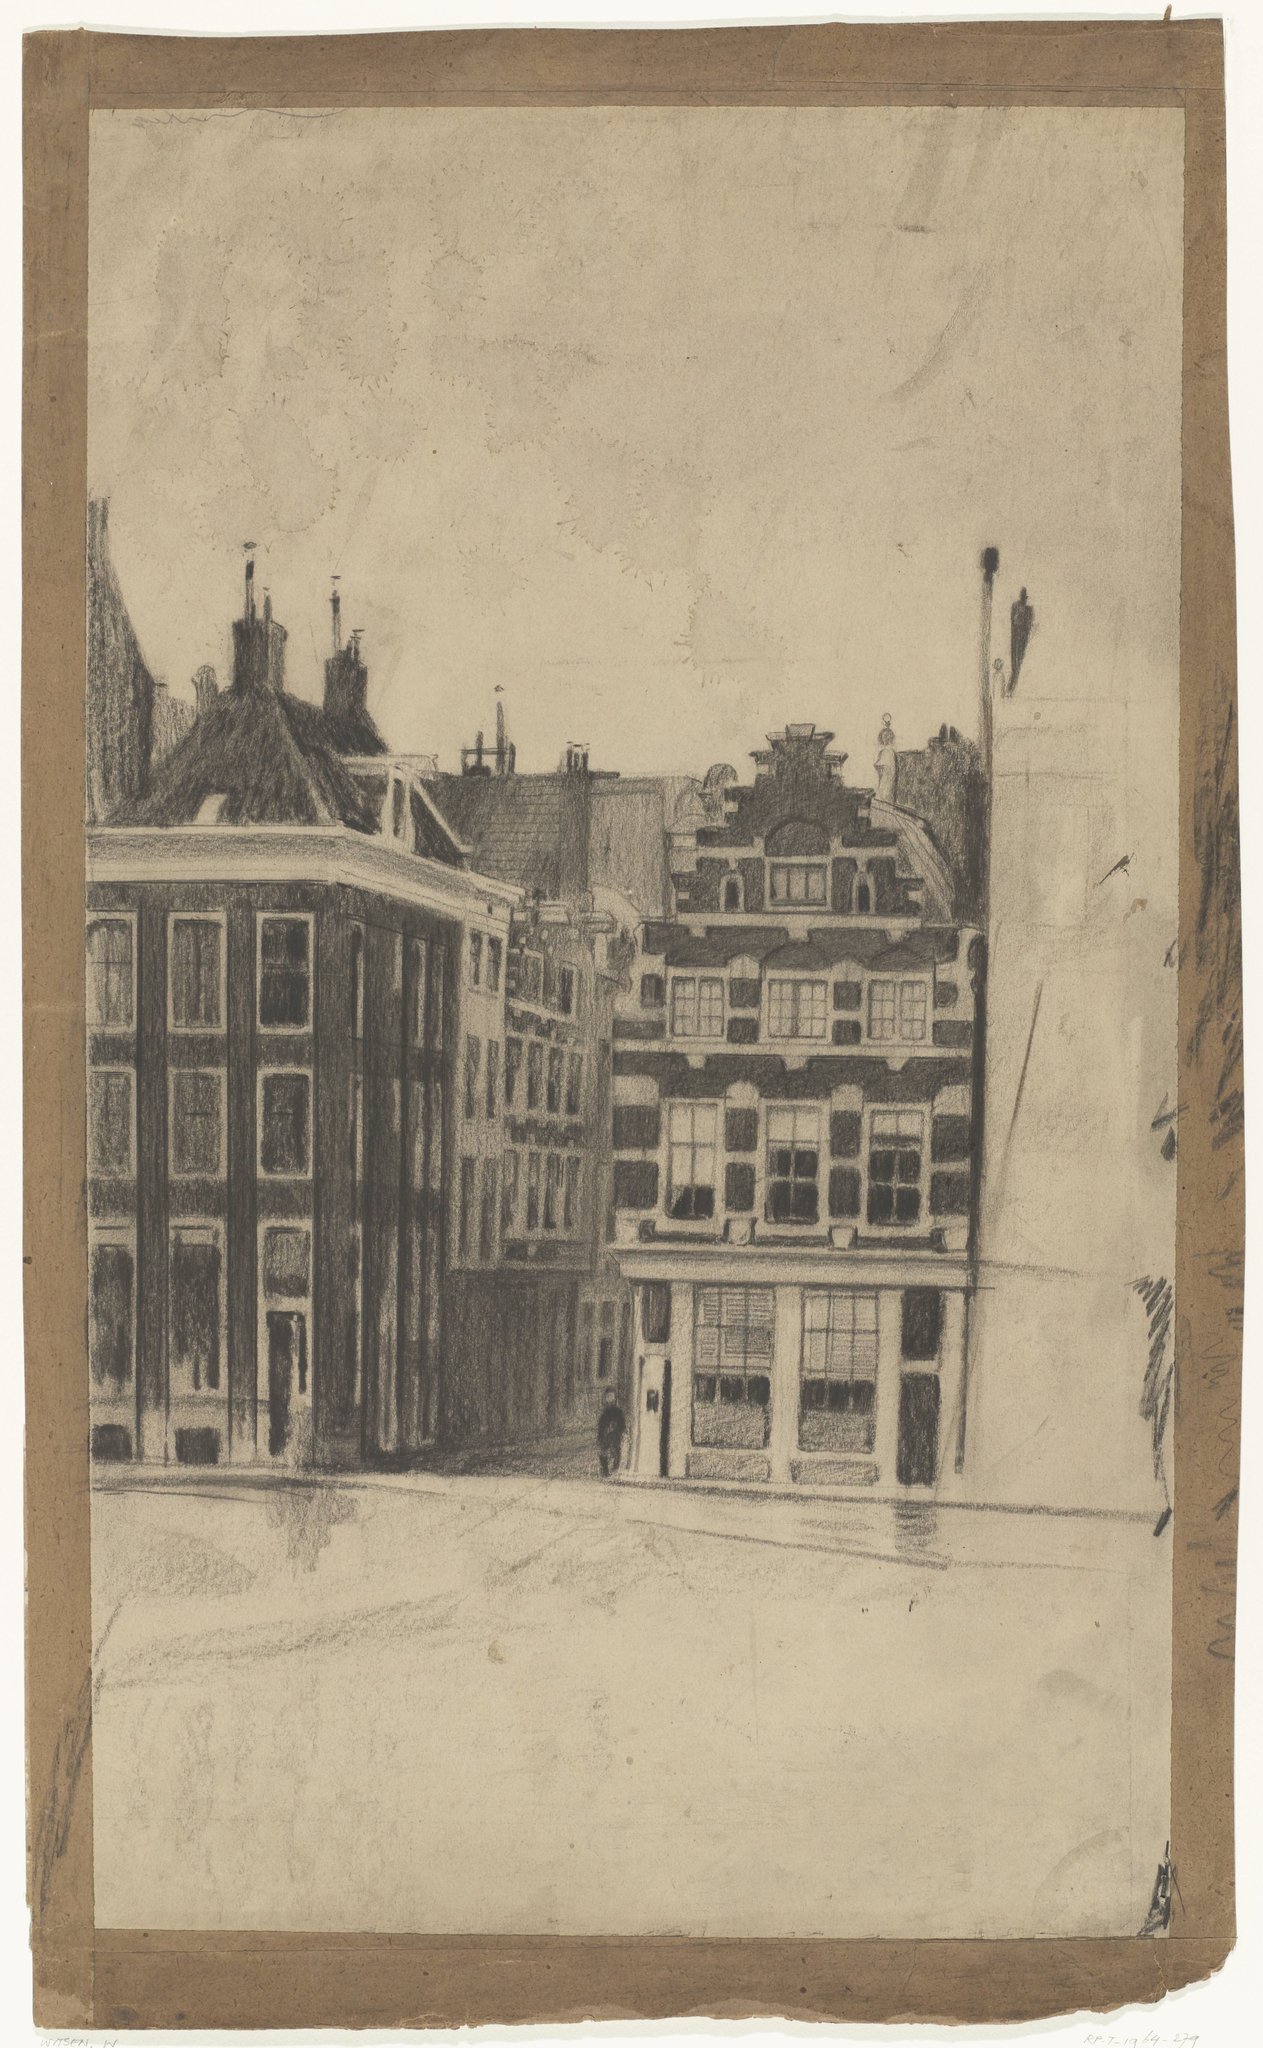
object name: drawing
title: De Halvemaansteeg te Amsterdam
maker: willem witsen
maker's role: draughtsman, painter, print maker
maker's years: 1860-1923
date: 1907-1909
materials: chalk, paper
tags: street